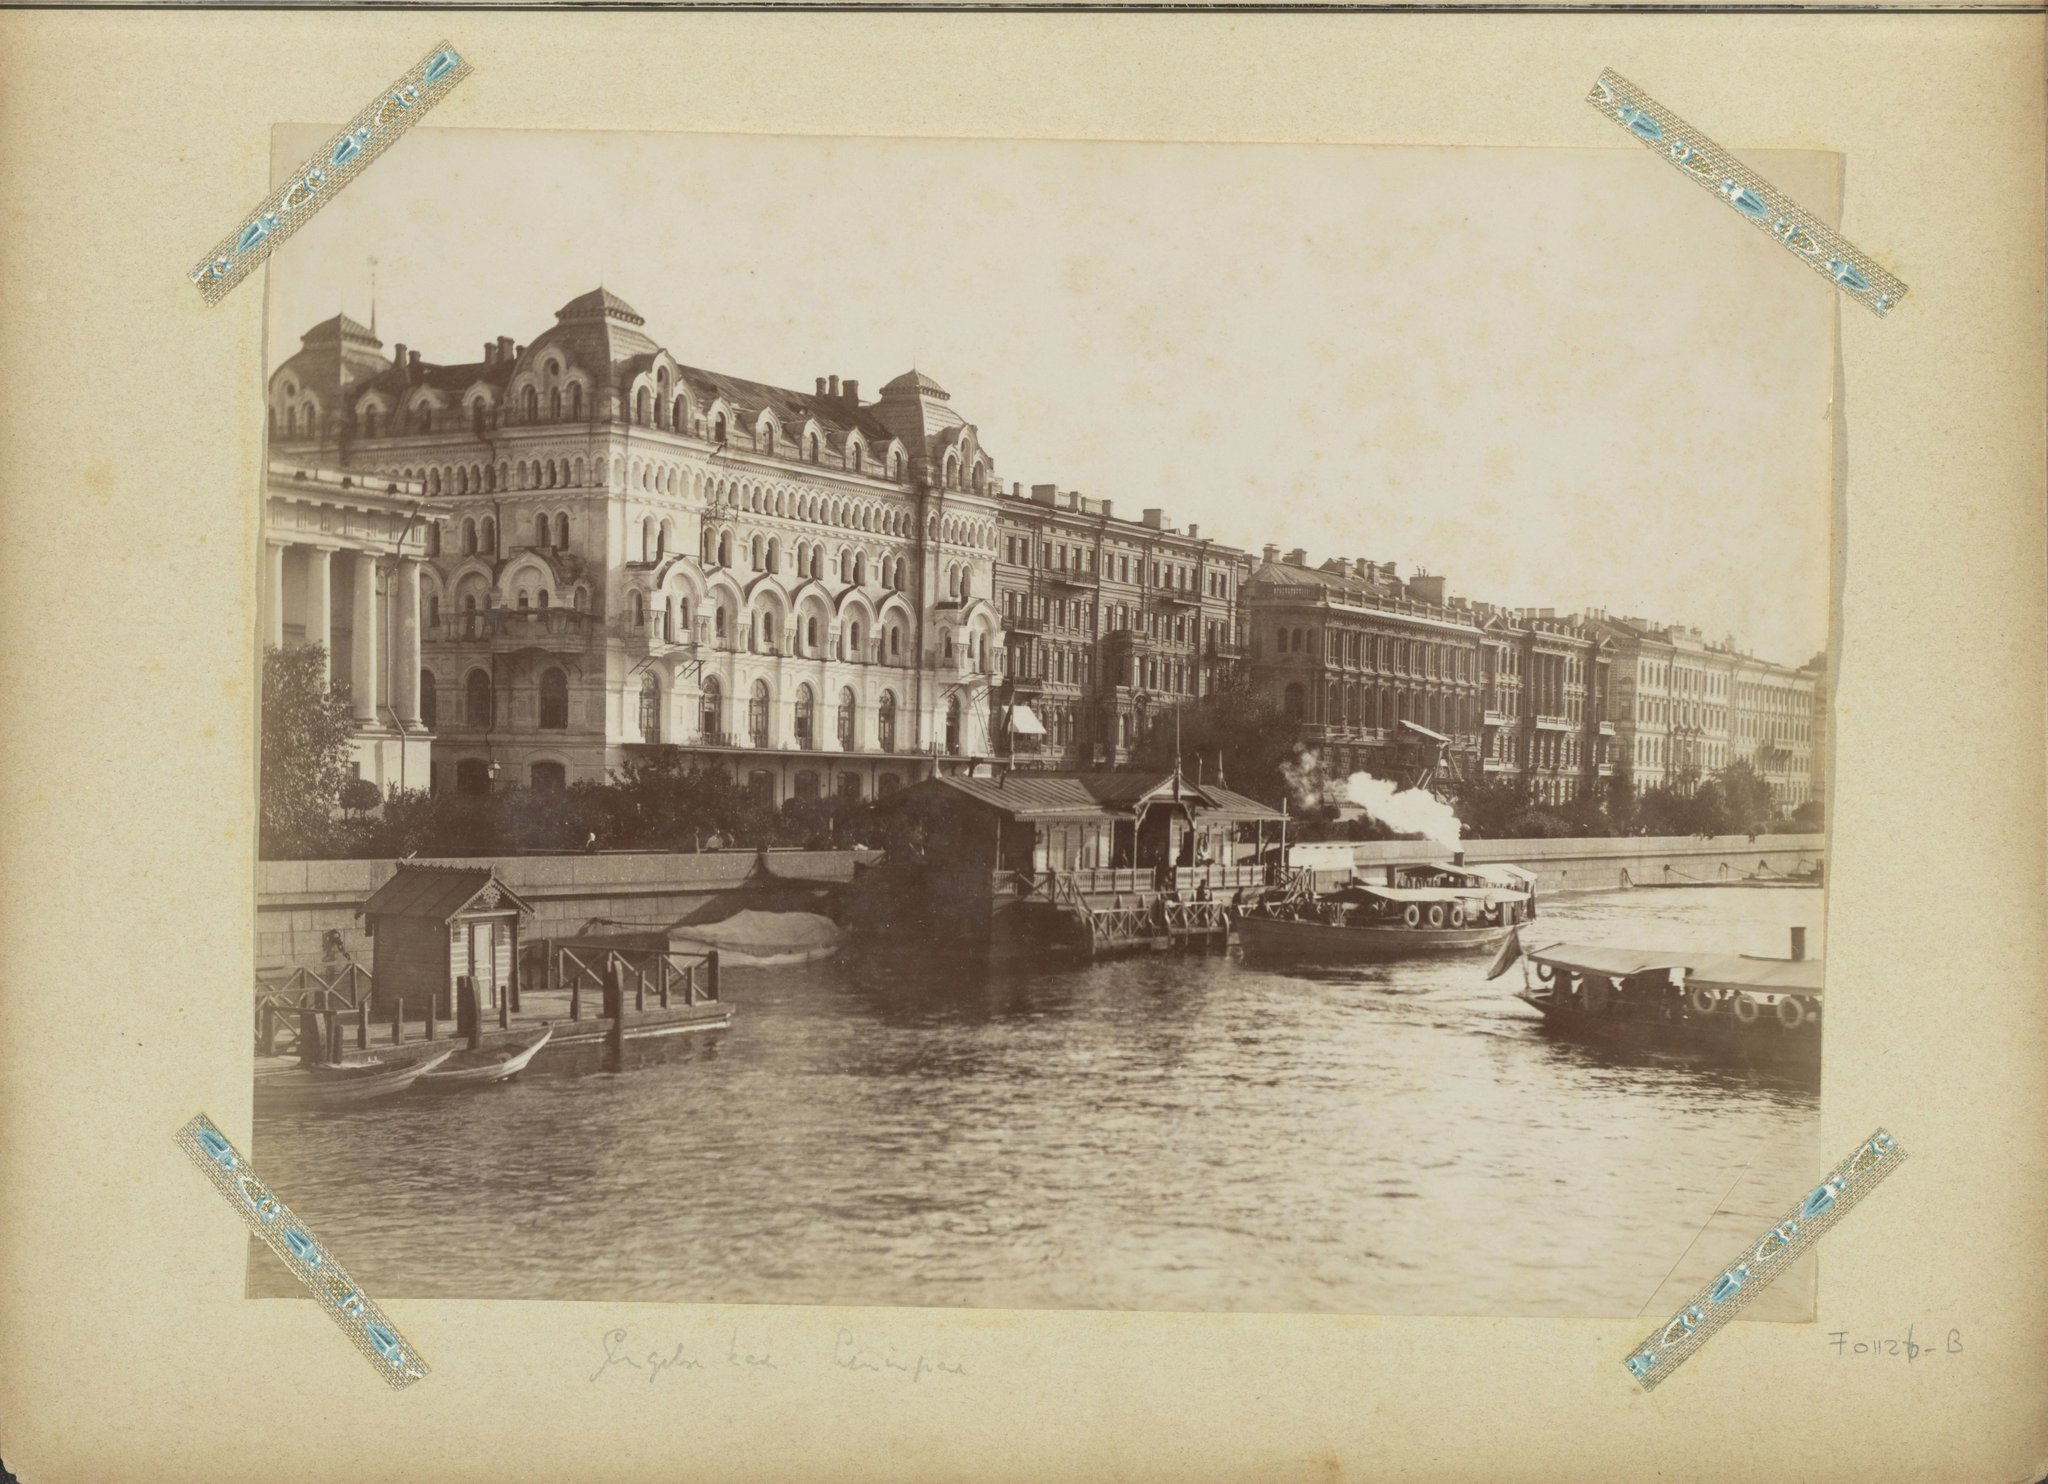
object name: photograph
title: Engelse Kade langs Neva in Sint-Petersburg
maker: Anonymous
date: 1890-1900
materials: photographic support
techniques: albumen print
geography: sint-petersburg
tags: quay (+ city(-scape) with figures, staffage)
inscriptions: inscription: ‘Theatre Panaeff’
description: Onderdeel van Fotoalbum met opnames van bezienswaardigheden in Georgië, Sint-Petersburg en Moskou.